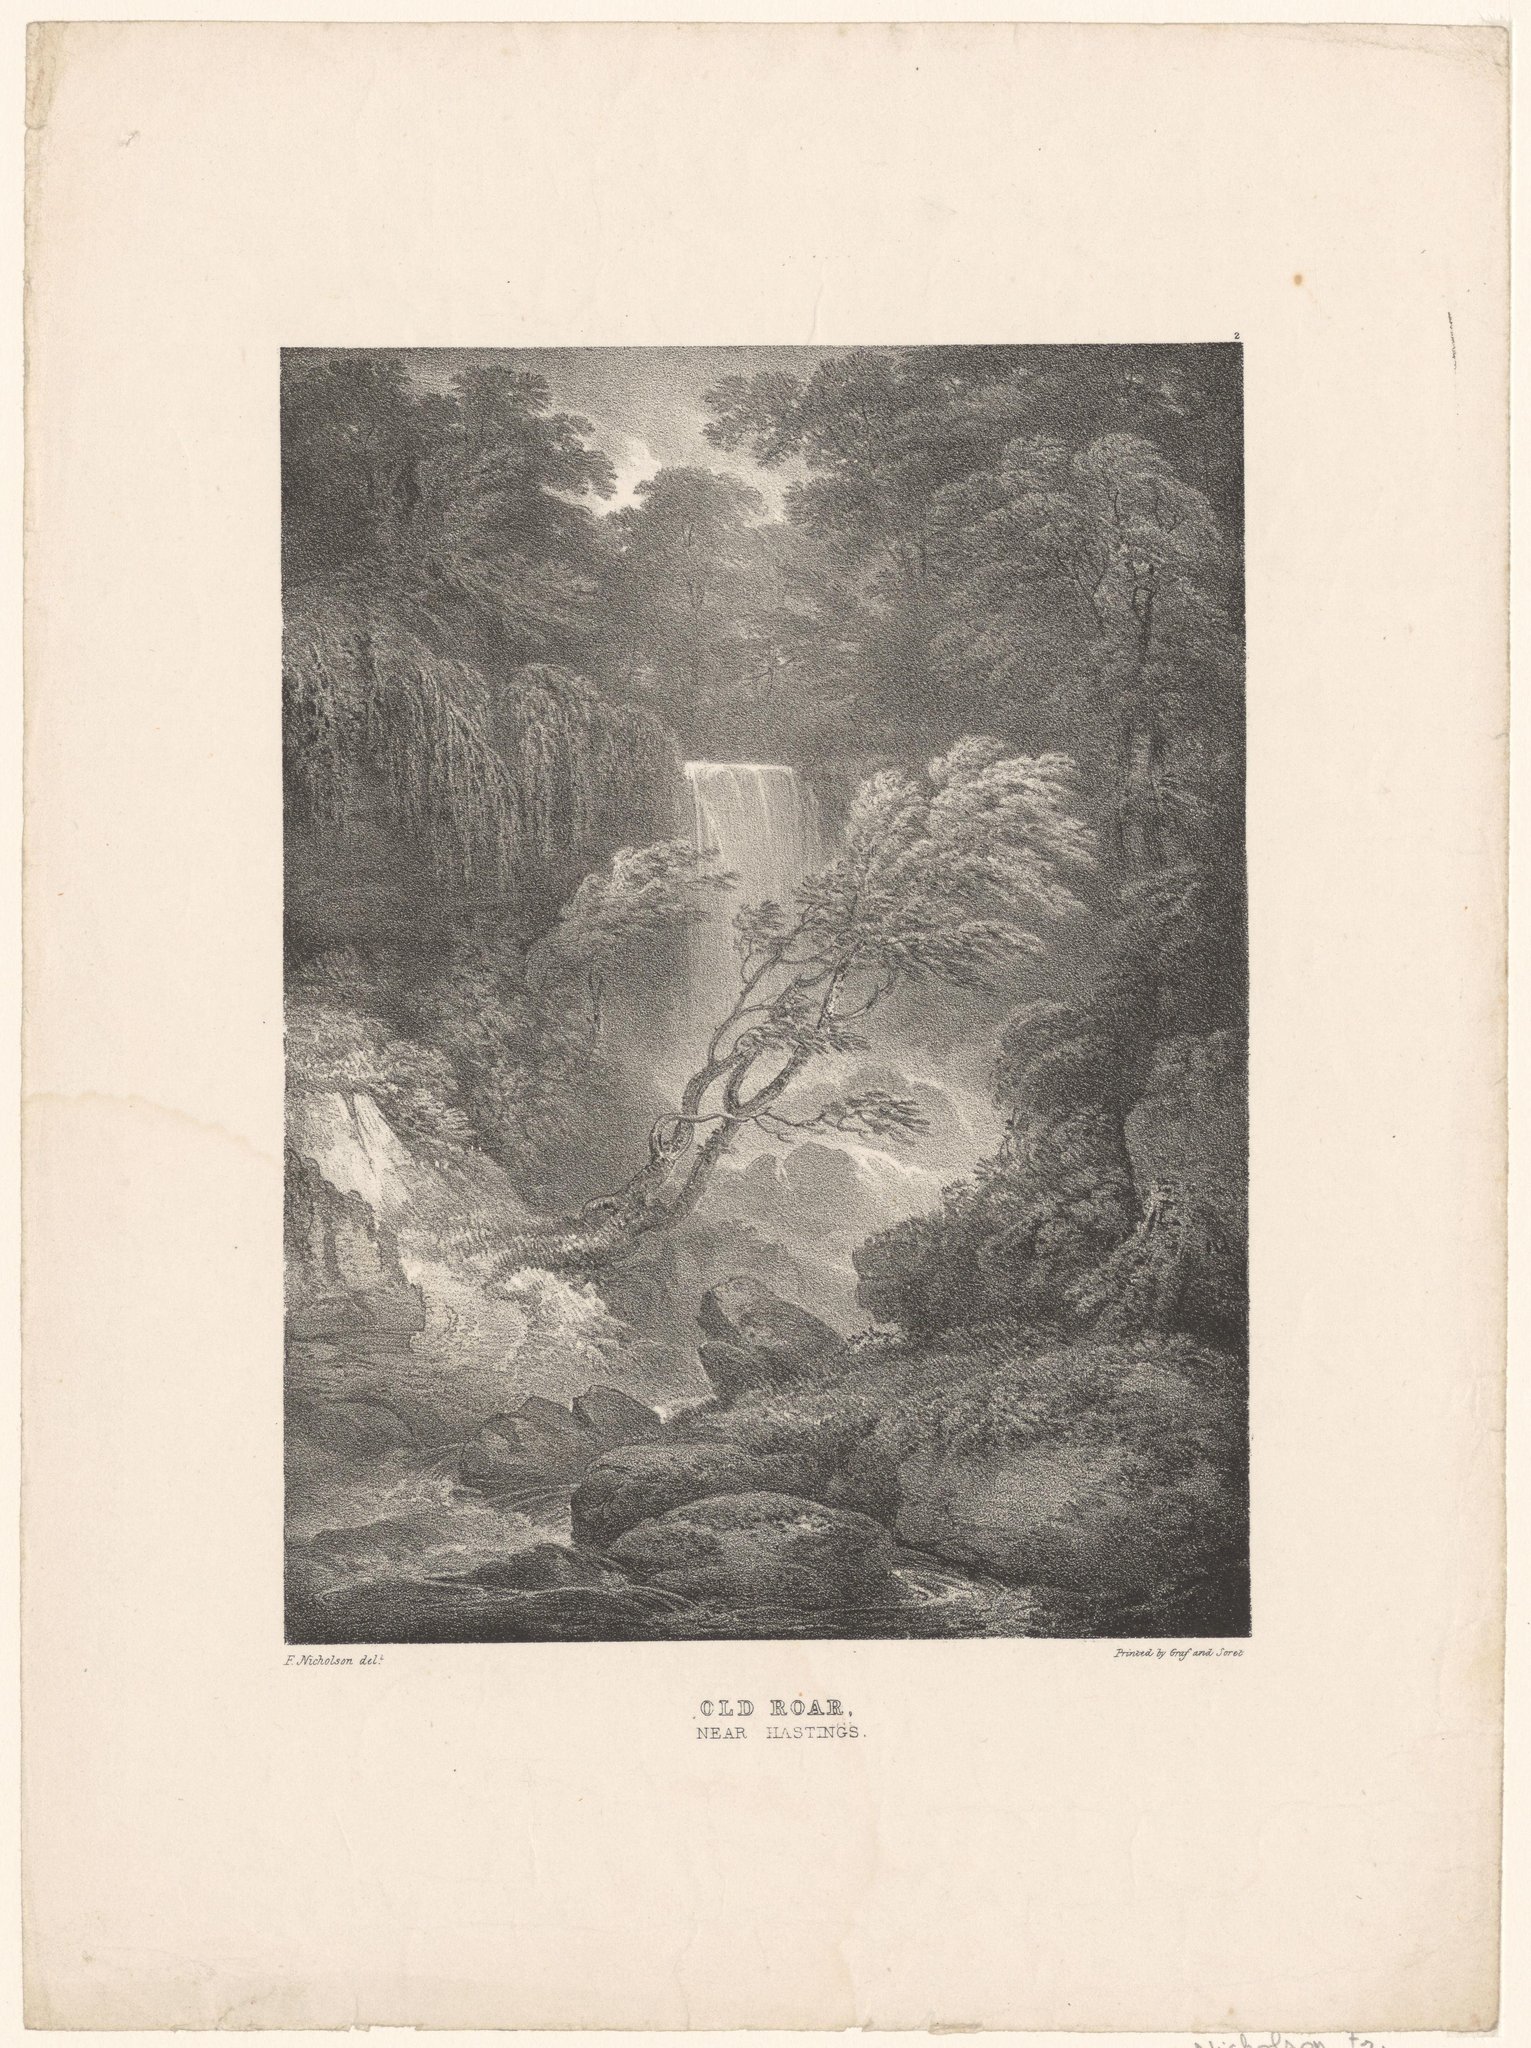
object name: print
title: Waterval nabij Hastings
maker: francis nicholson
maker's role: print maker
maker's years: 1753-1844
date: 1820-1844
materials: paper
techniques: lithograph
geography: london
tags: waterfall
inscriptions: collector's mark: Lugt 2228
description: Prent maakt mogelijk deel uit van een serie met landschappen en stadsgezichten. Over deze serie is verder niets bekend. Het betreft voornamelijk gezichten in Engeland.